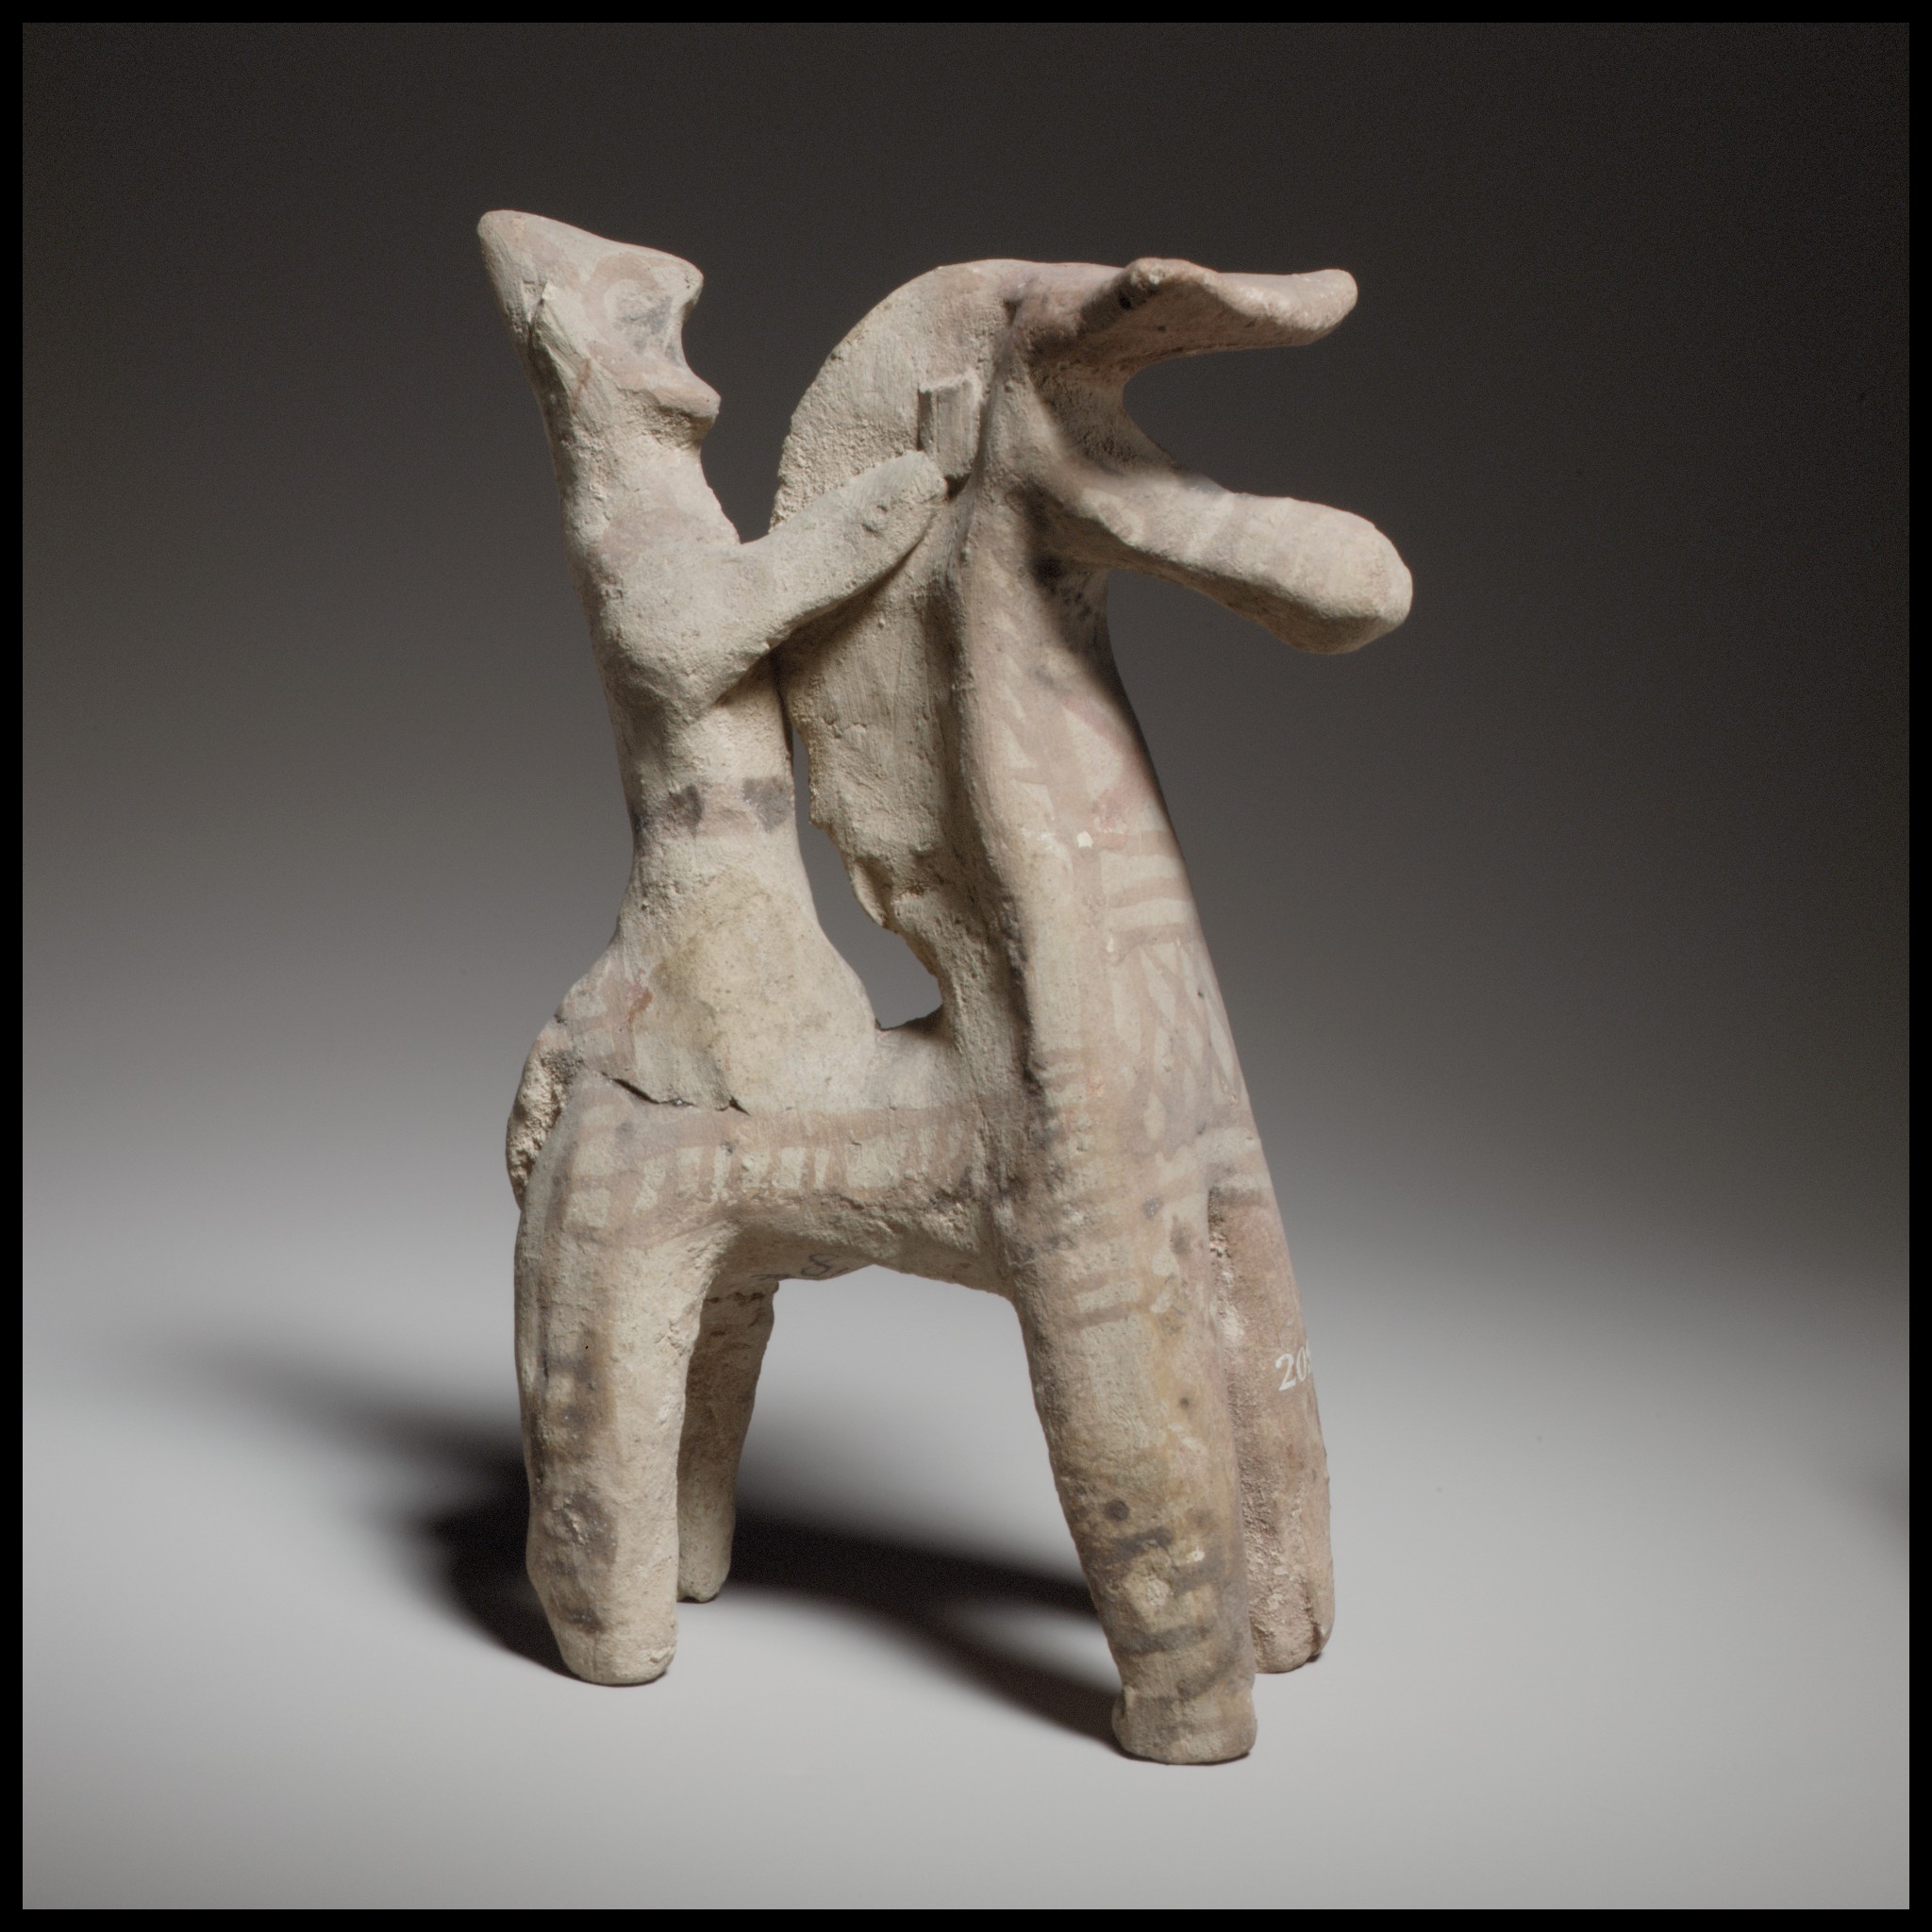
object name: statue of a man on a horse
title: Horse and rider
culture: cypriot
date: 750-600 BCE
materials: terracotta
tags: human figures,horses